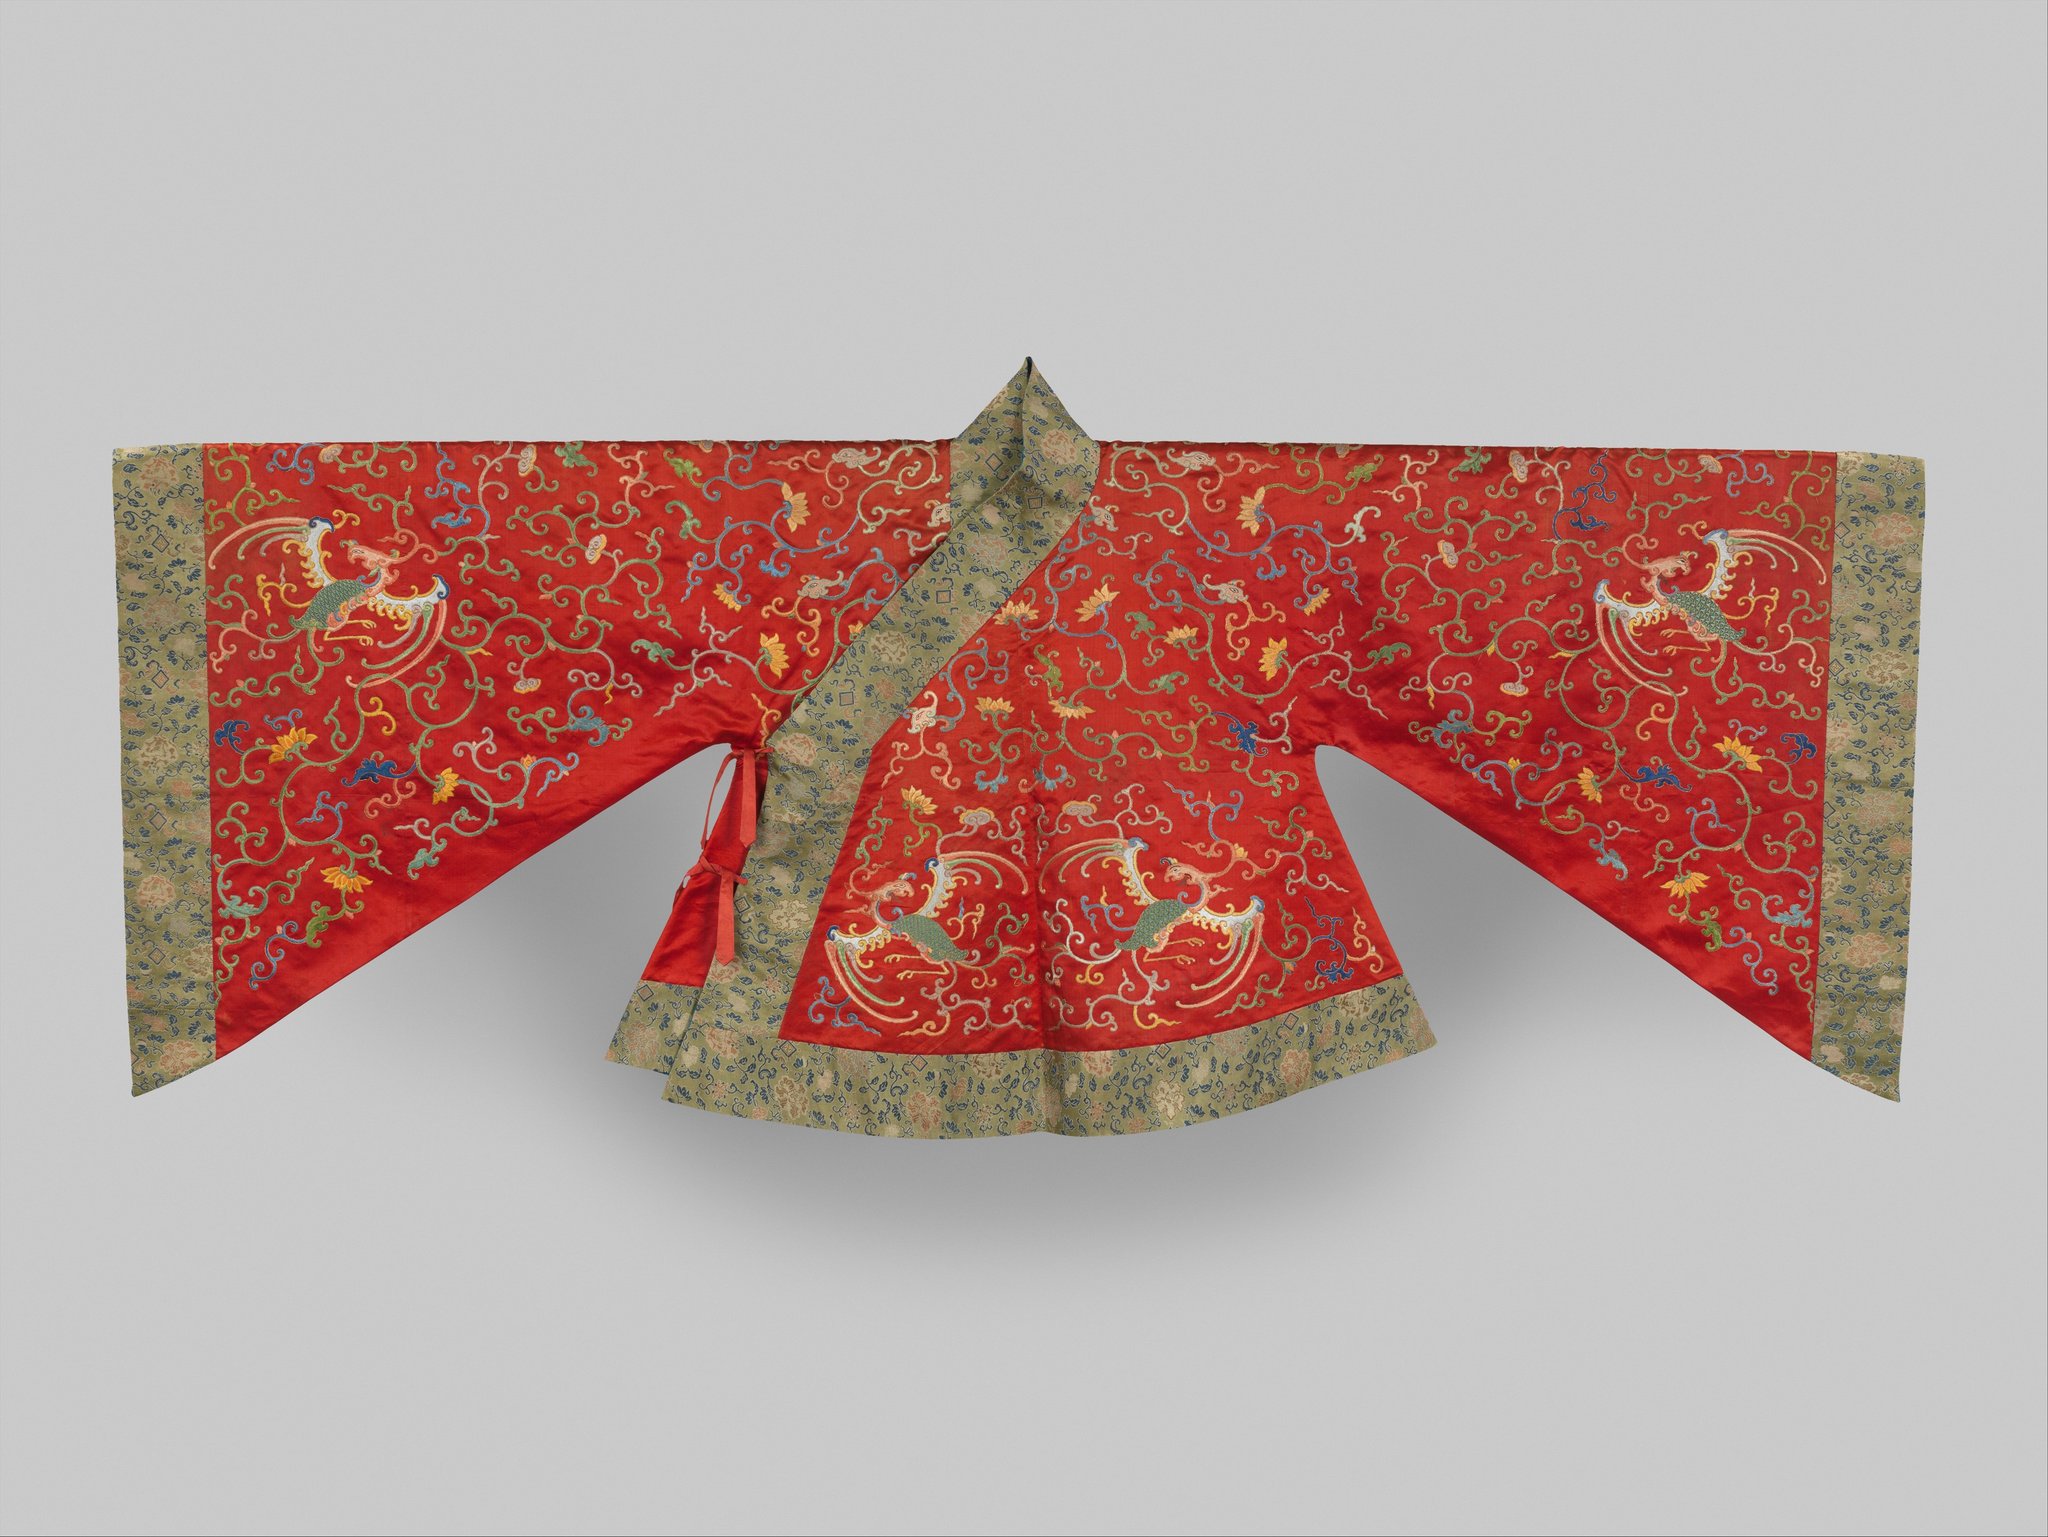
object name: coat, imperial theatrical, for court lady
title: Jacket from Theatrical Ensemble for a Female Role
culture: chinese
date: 1701-1800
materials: metal thread, silk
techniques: embroidery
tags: mythical creatures